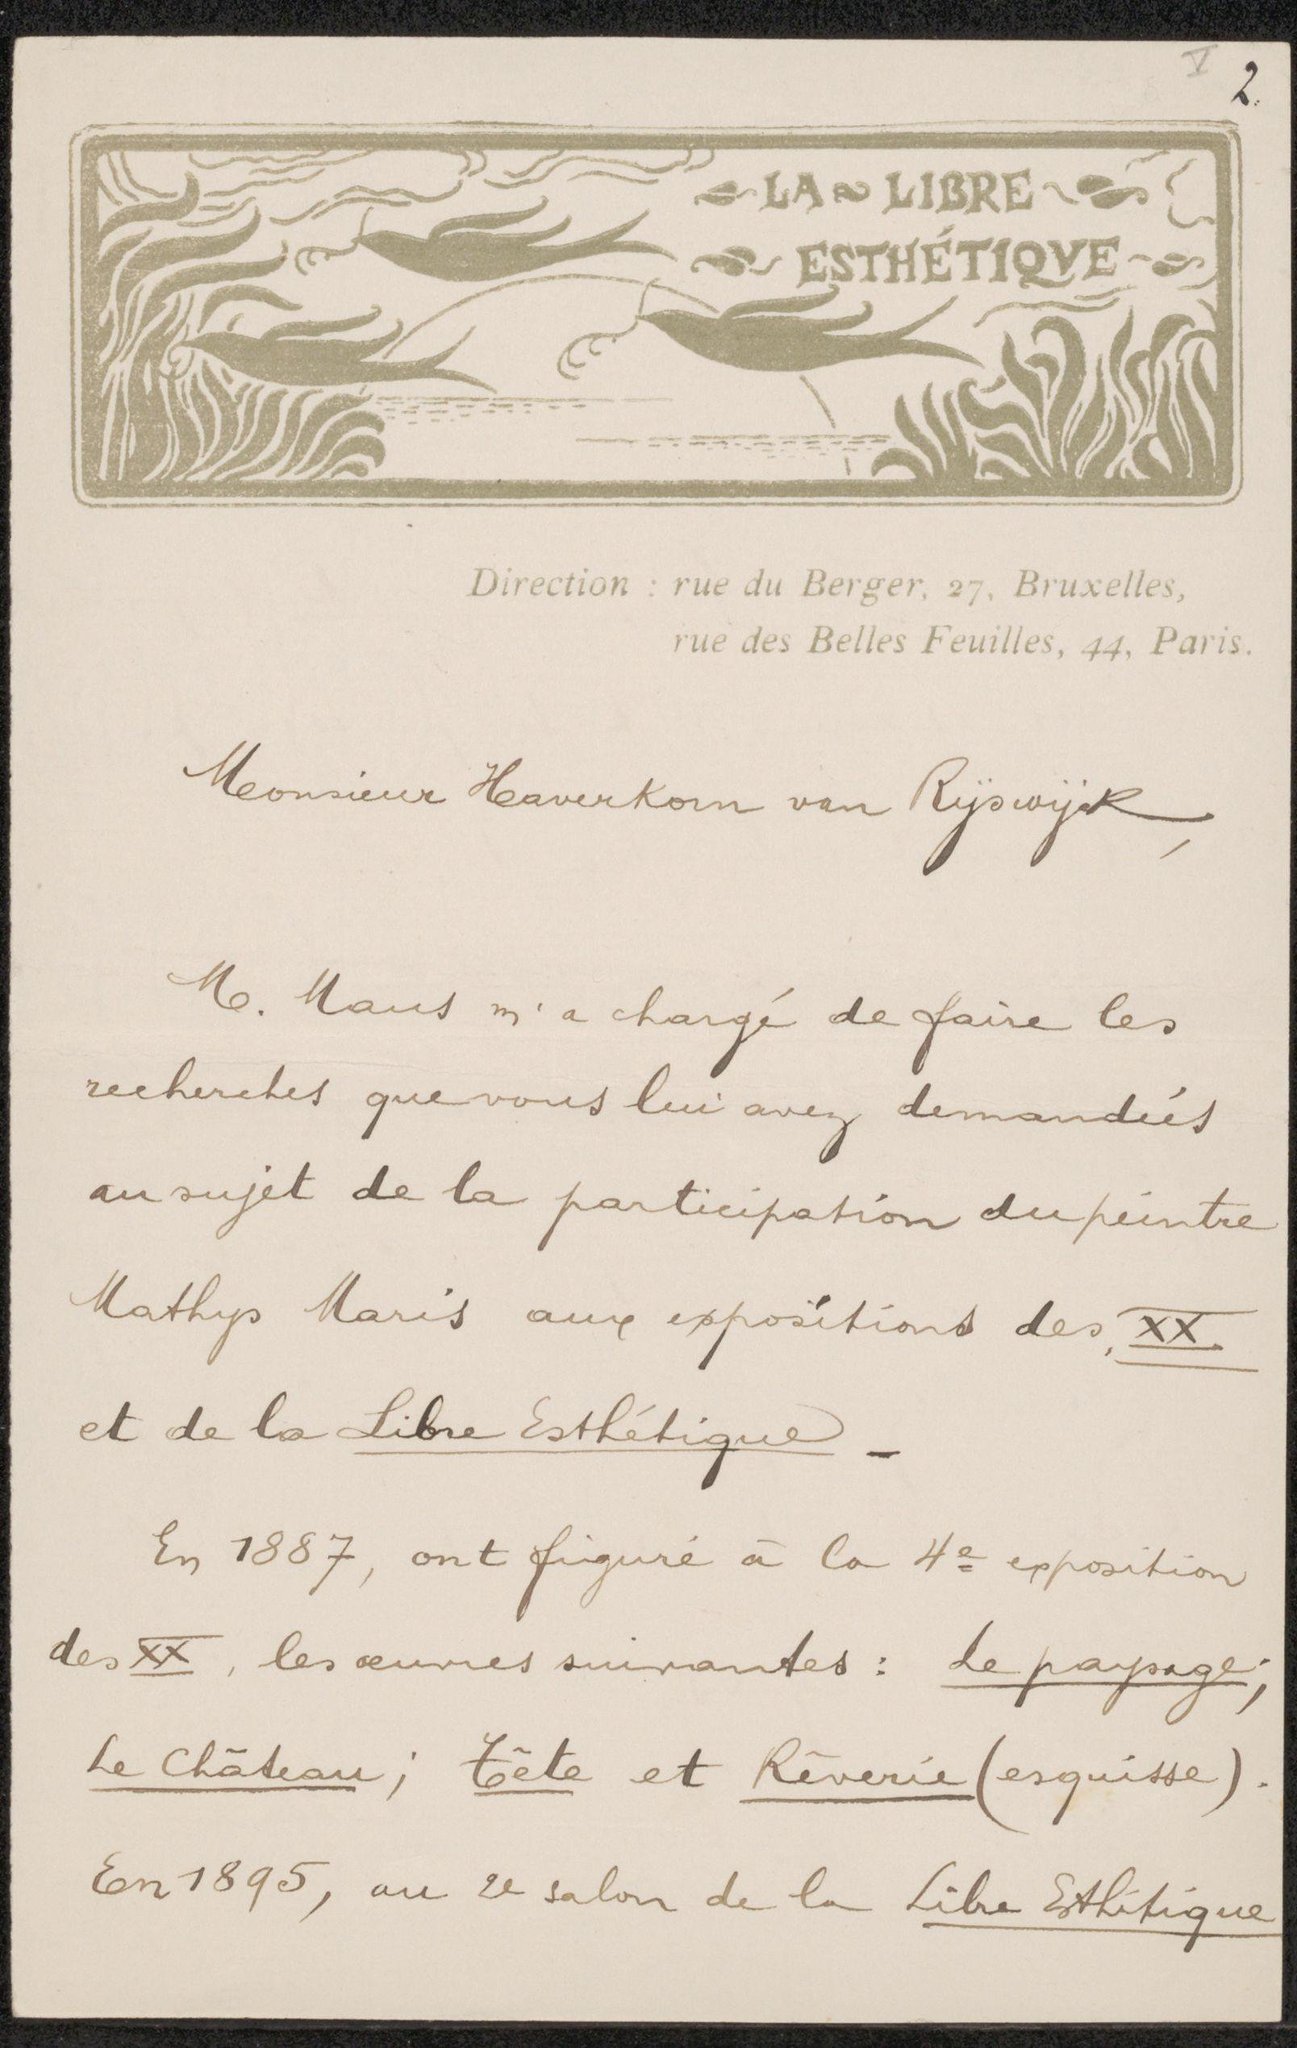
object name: letter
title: Brief aan Pieter Haverkorn van Rijsewijk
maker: delvaux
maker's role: schrijver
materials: ink, paper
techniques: pen, printing, writing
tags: the hague, london, painter, print maker, draughtsman, matthijs maris, pieter haverkorn van rijsewijk, octave maus, drawing, brussels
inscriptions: watermark